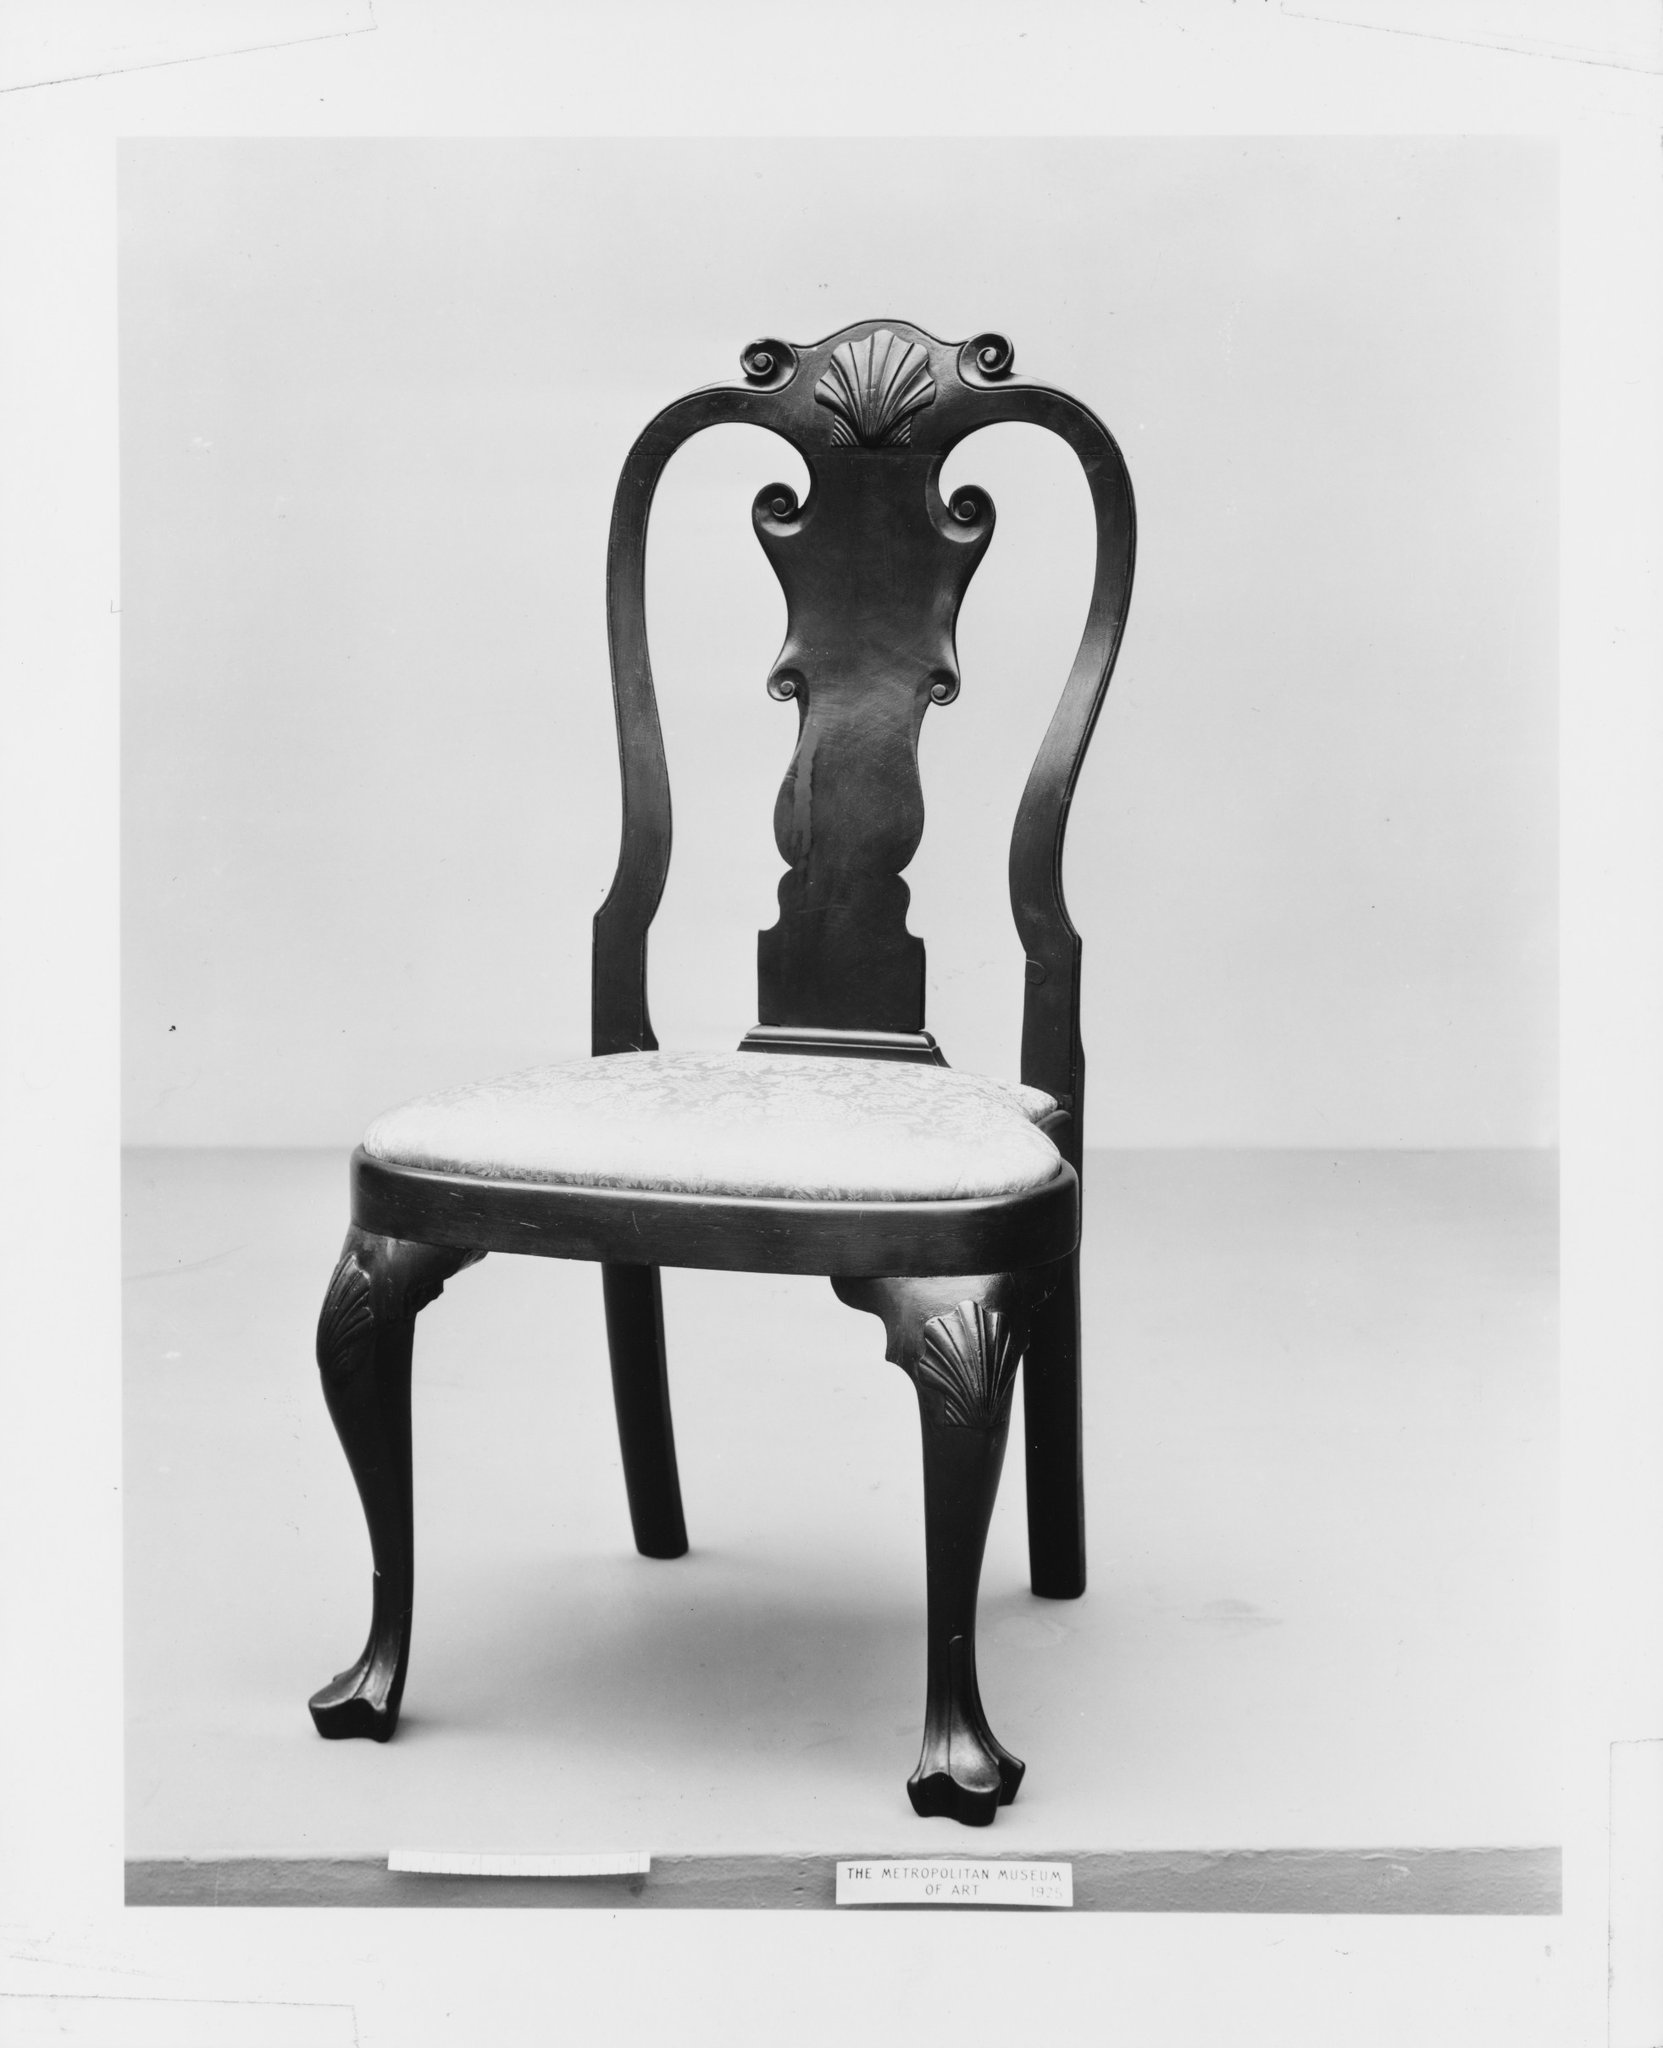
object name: side chair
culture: american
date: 1740-1760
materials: wood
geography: united states